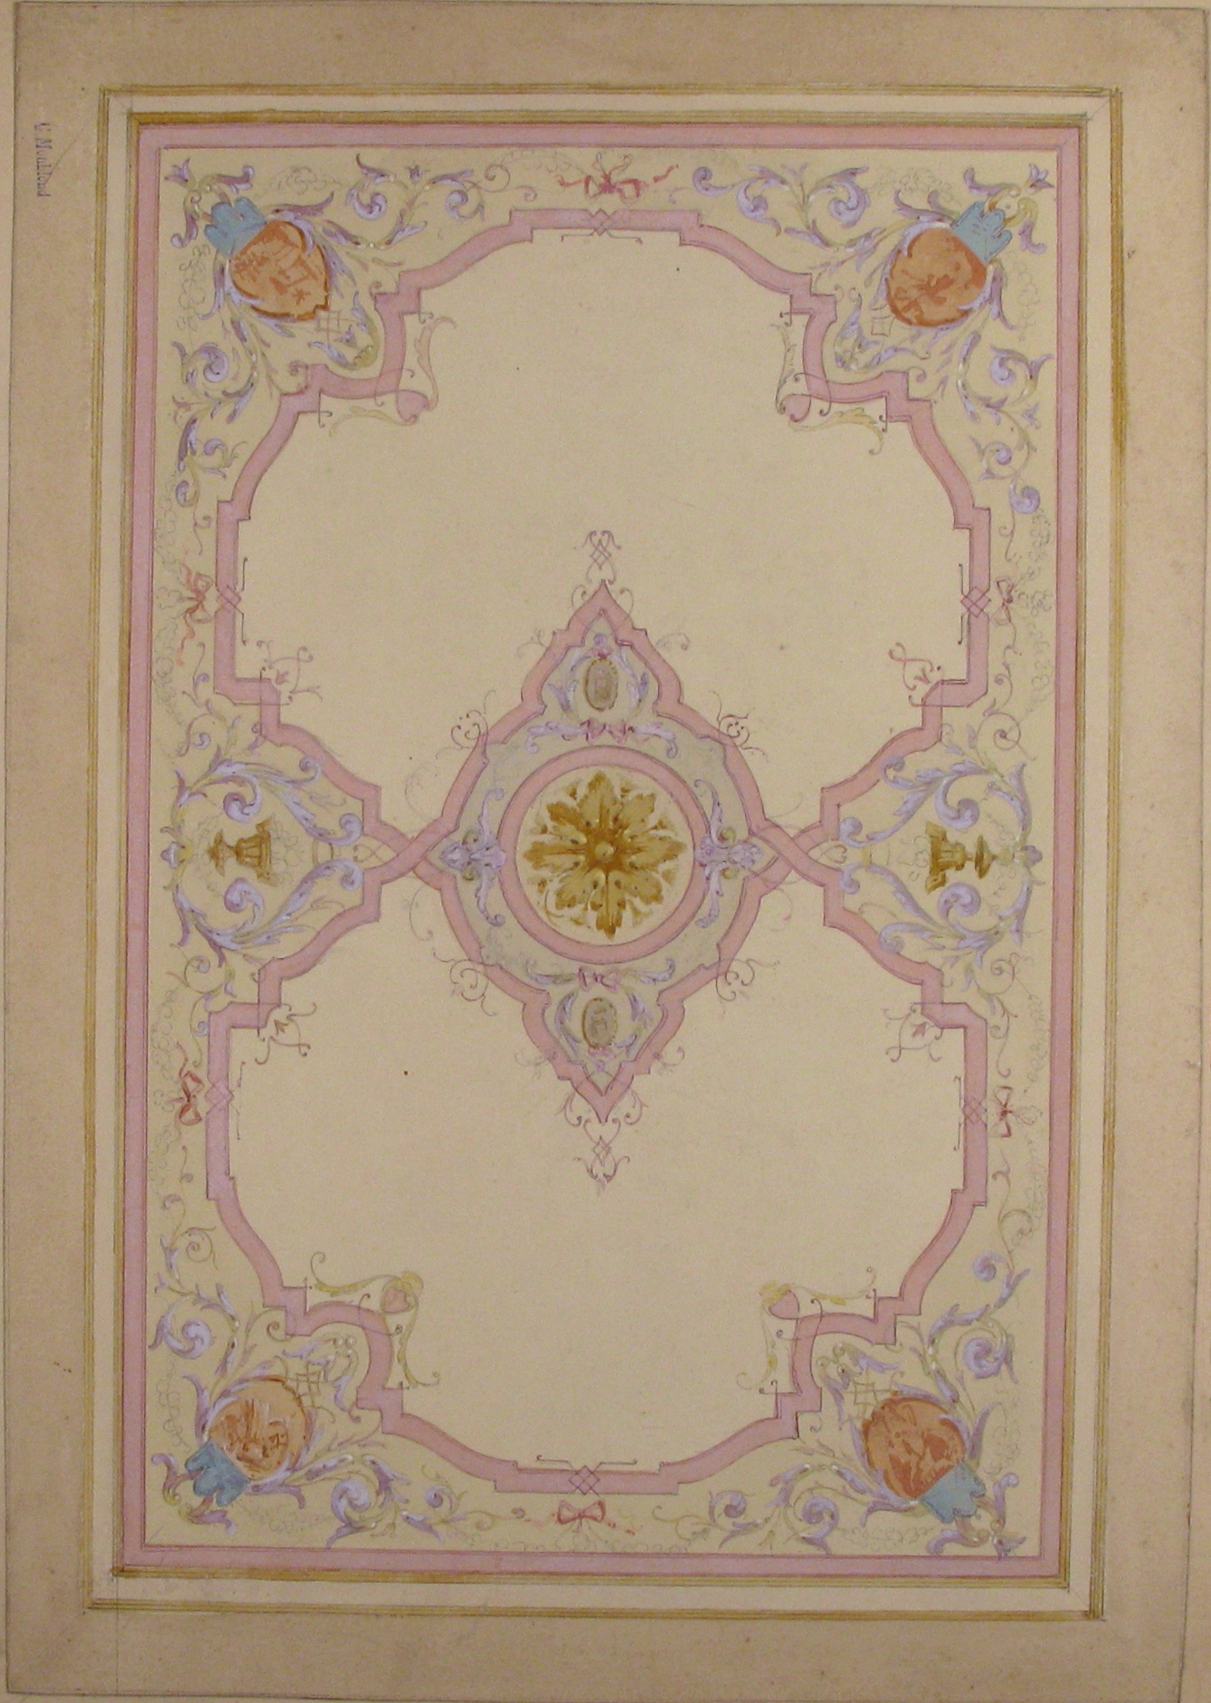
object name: drawing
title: Design for Ceiling Decorated with Lavender Arabesques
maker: charles monblond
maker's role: artist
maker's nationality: french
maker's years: 1800-1900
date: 1801-1900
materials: graphite, watercolor